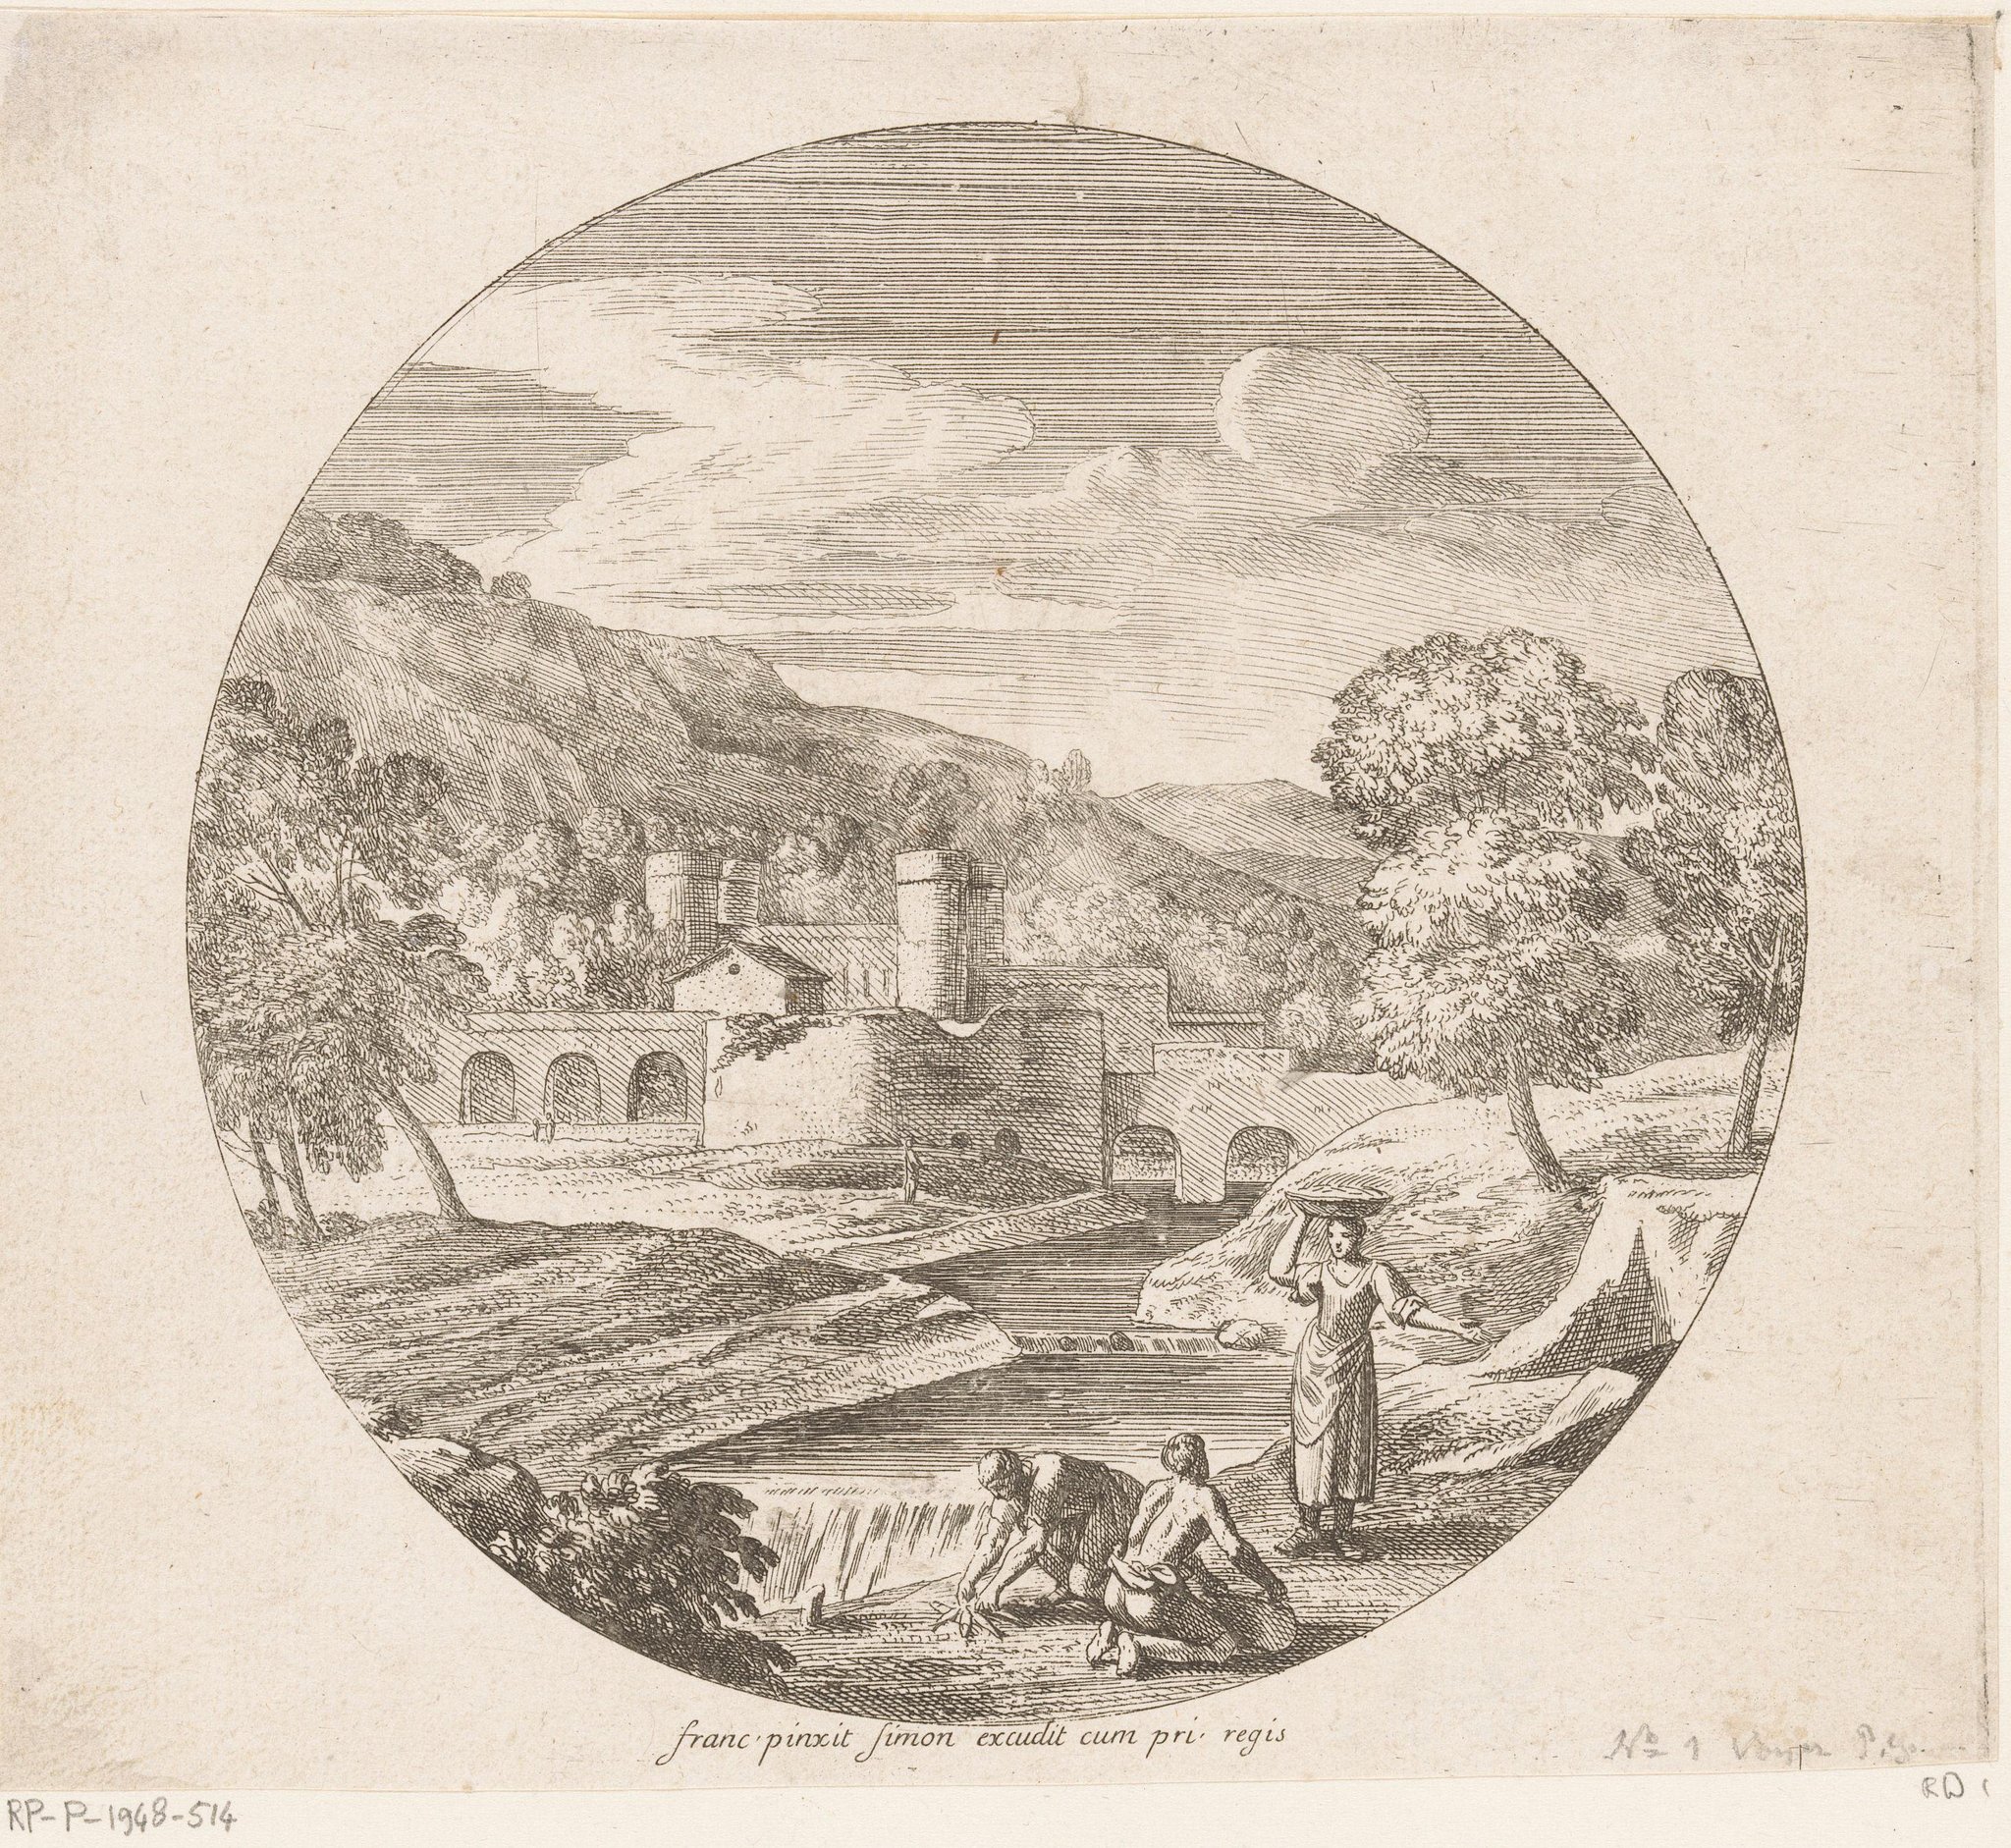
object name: print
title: Paysages de forme ronde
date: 1690-1730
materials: paper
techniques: etching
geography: france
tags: landscapes in the temperate zone - hh - ideal landscapes, river, fisherman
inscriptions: collector's mark: Lugt 2228